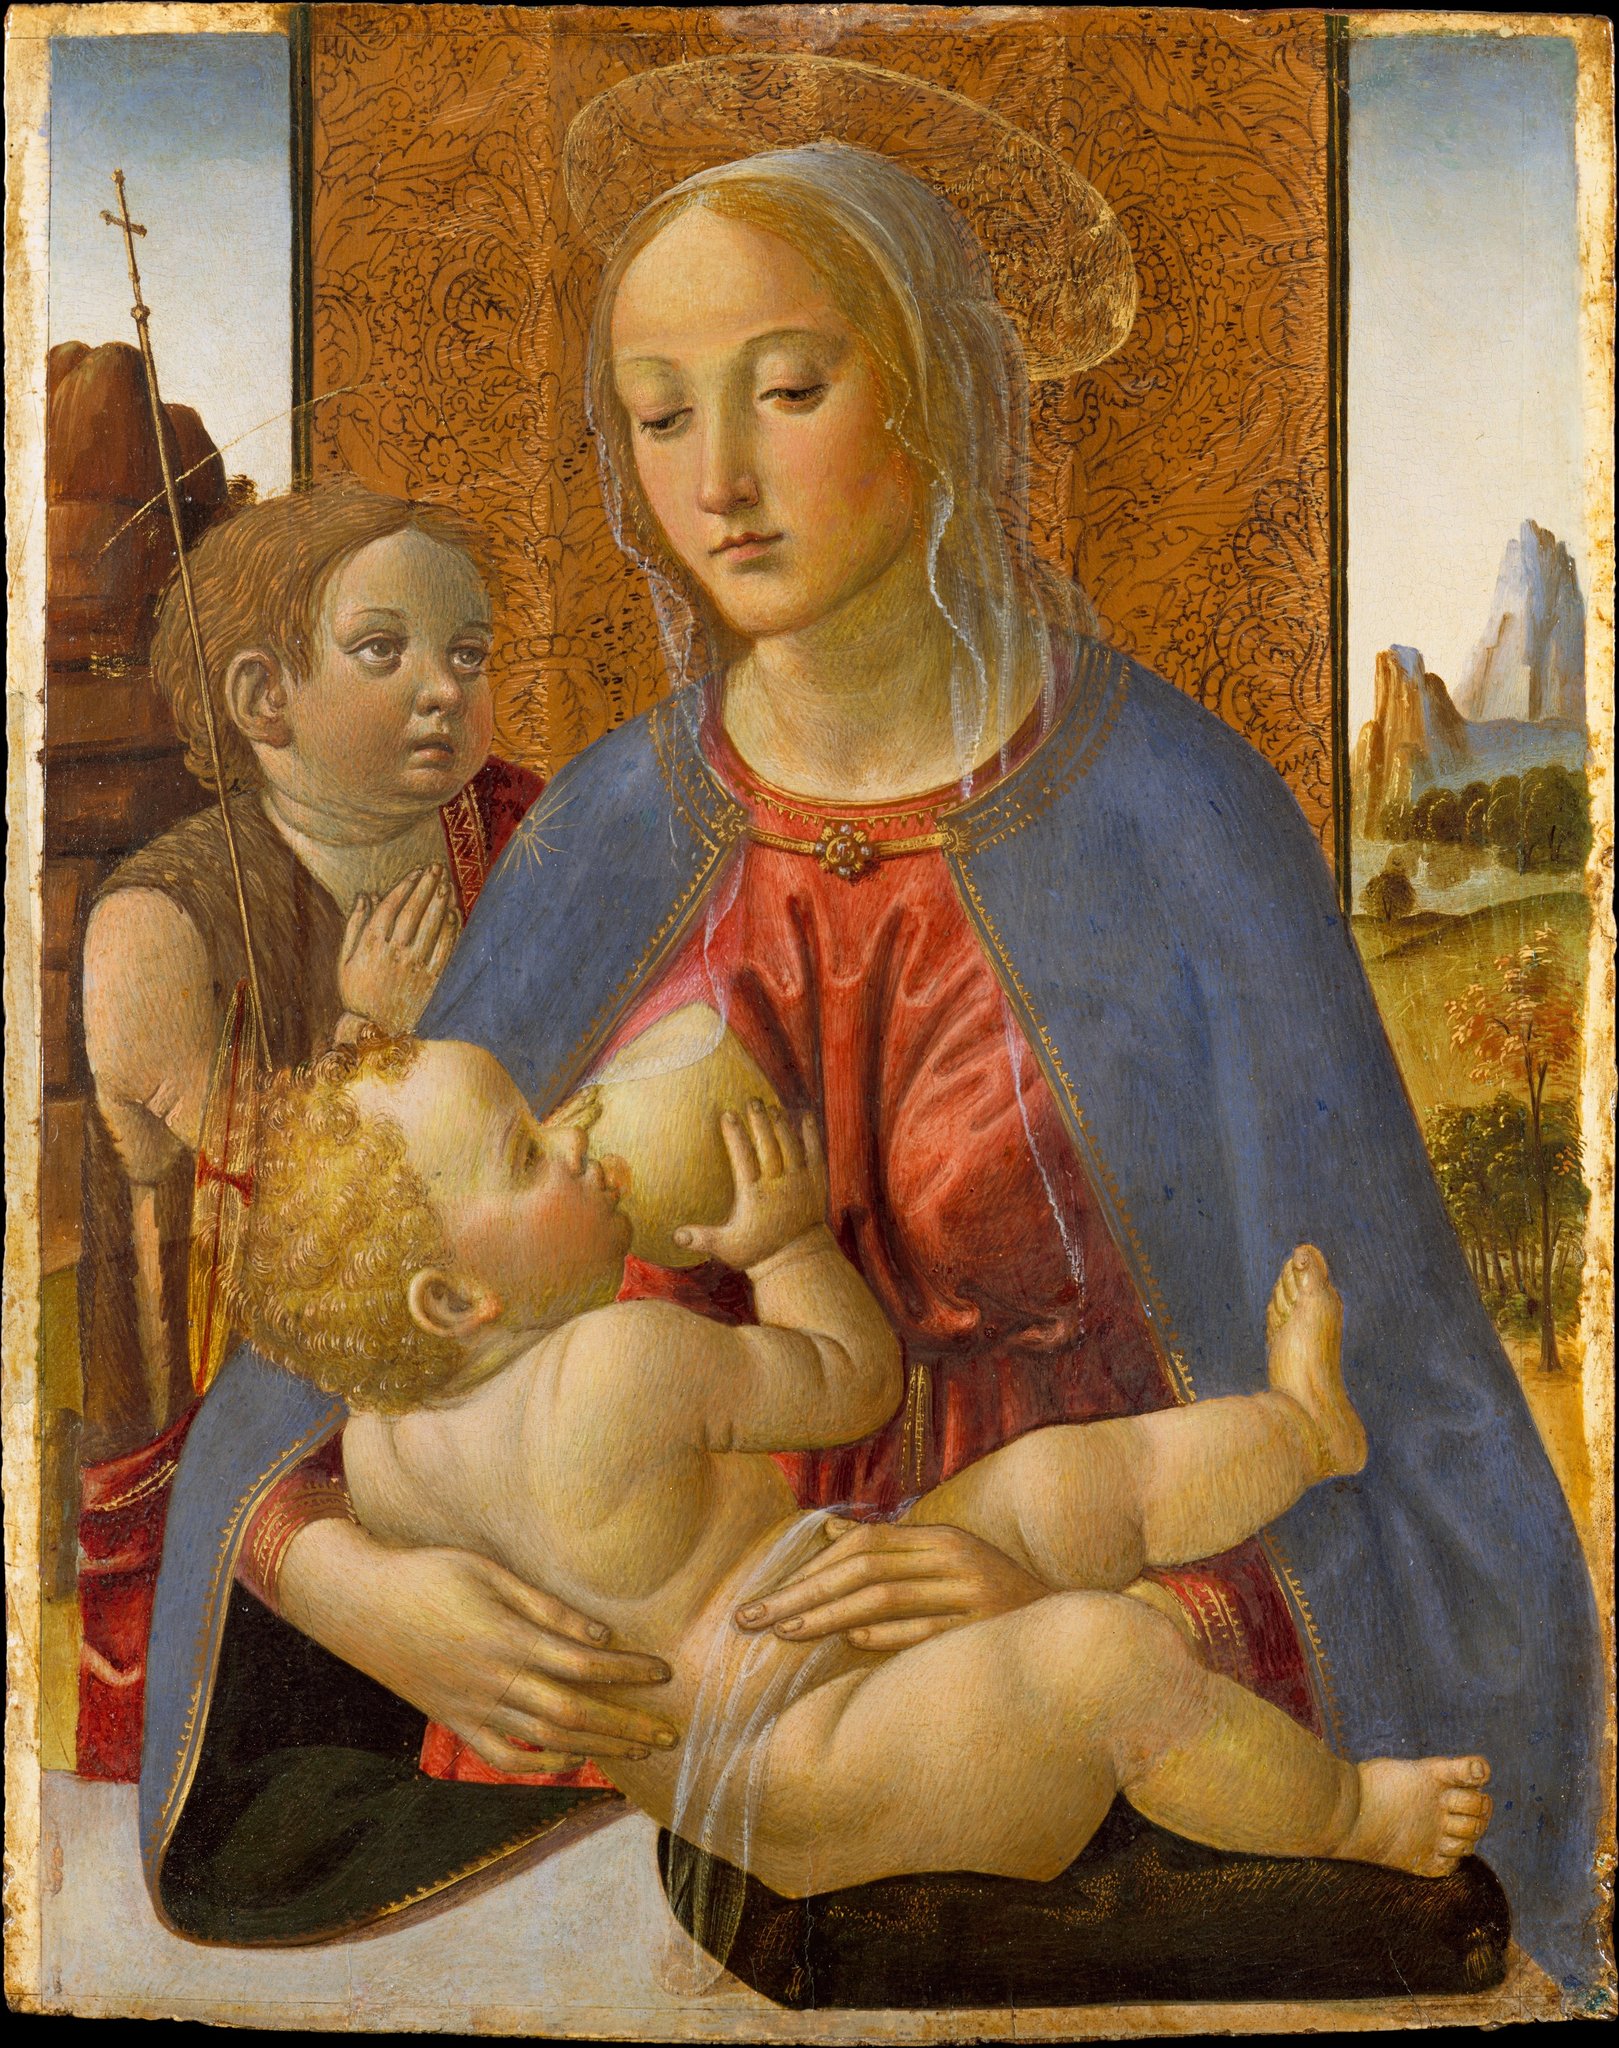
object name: painting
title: Madonna and Child with the Young Saint John the Baptist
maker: cosimo rosselli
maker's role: artist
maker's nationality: italian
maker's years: 1440-1507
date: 1490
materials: gold, oil, paint, wood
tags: madonna and child,saint john the baptist